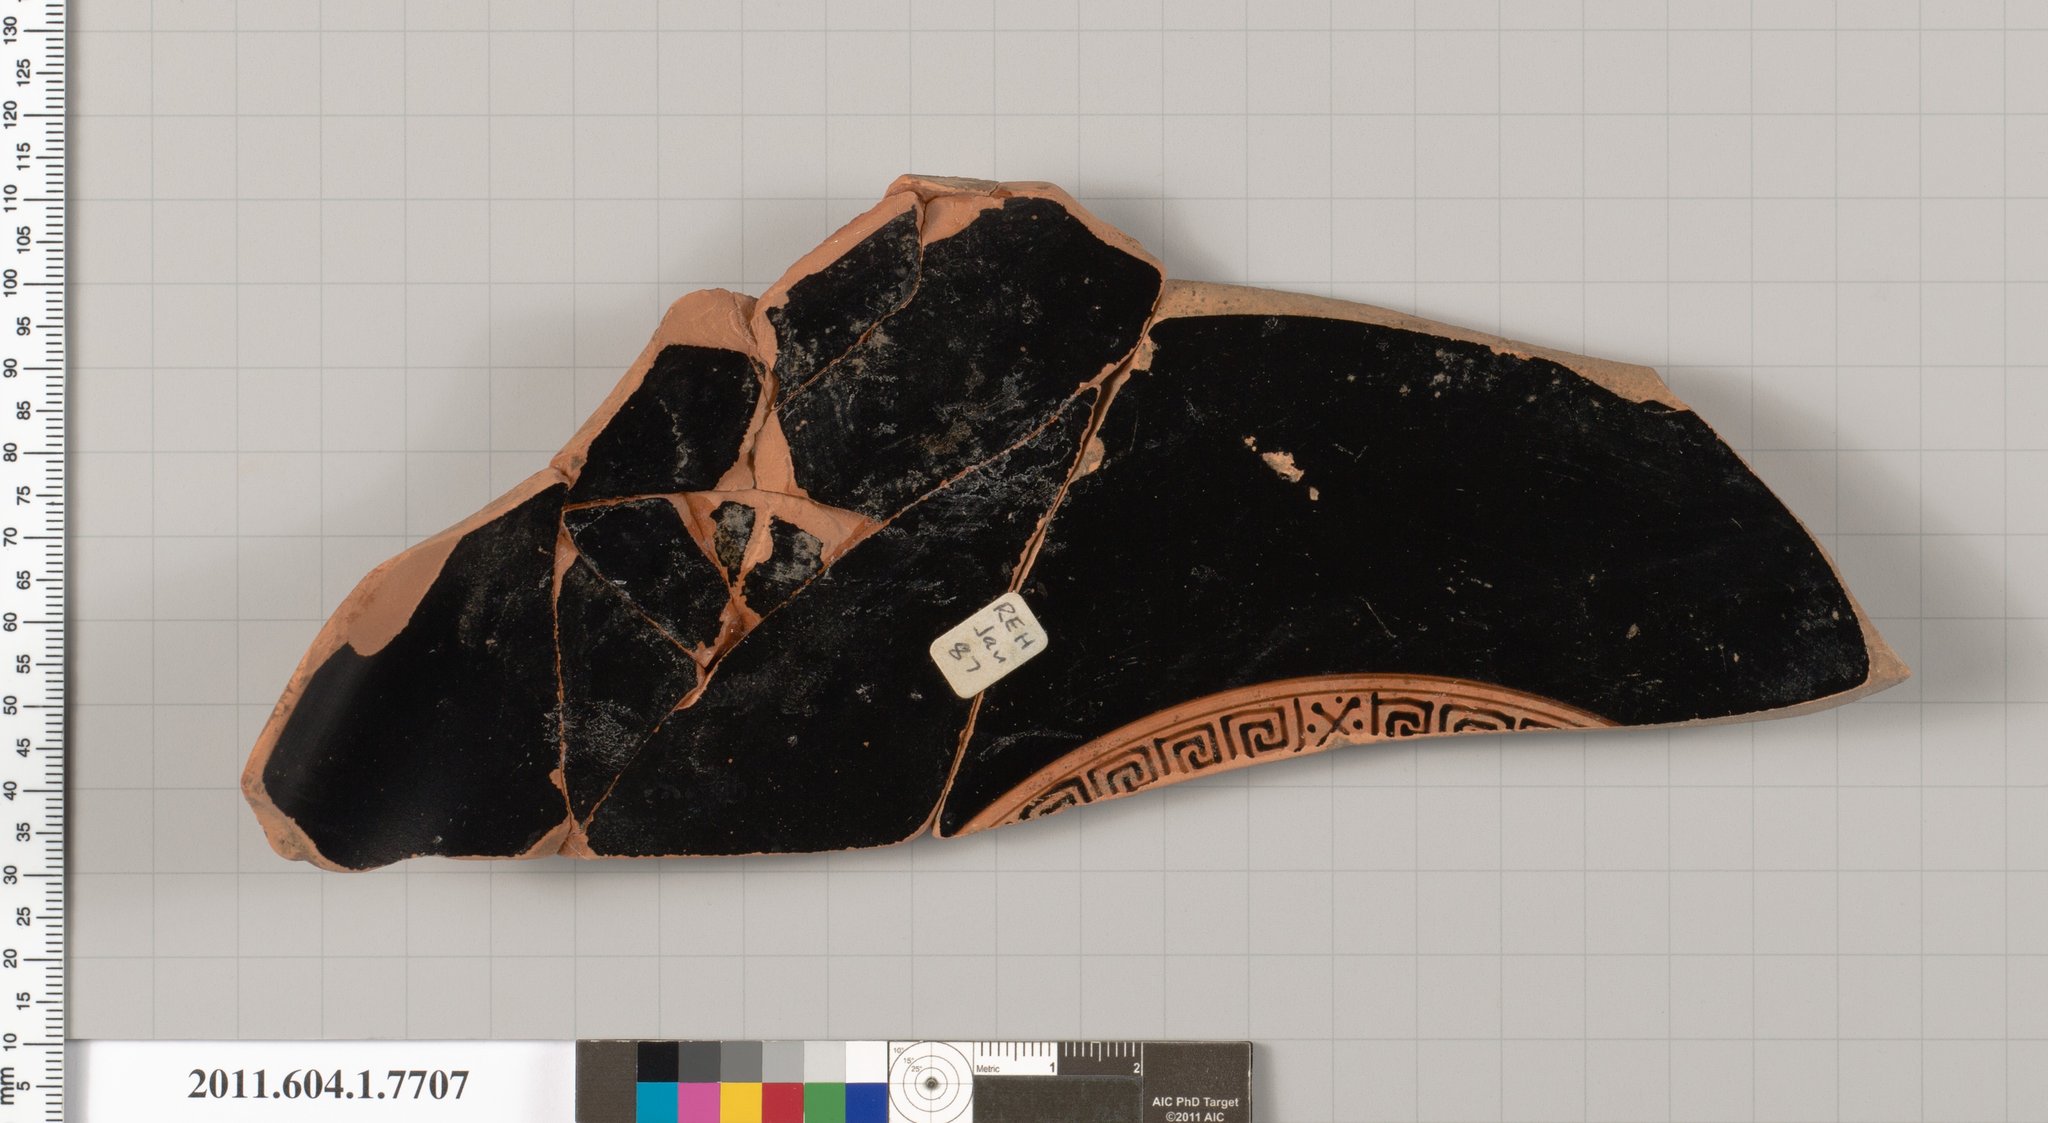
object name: kylix fragment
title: Terracotta fragment of a kylix (drinking cup)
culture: greek, attic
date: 470-460 BCE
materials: terracotta